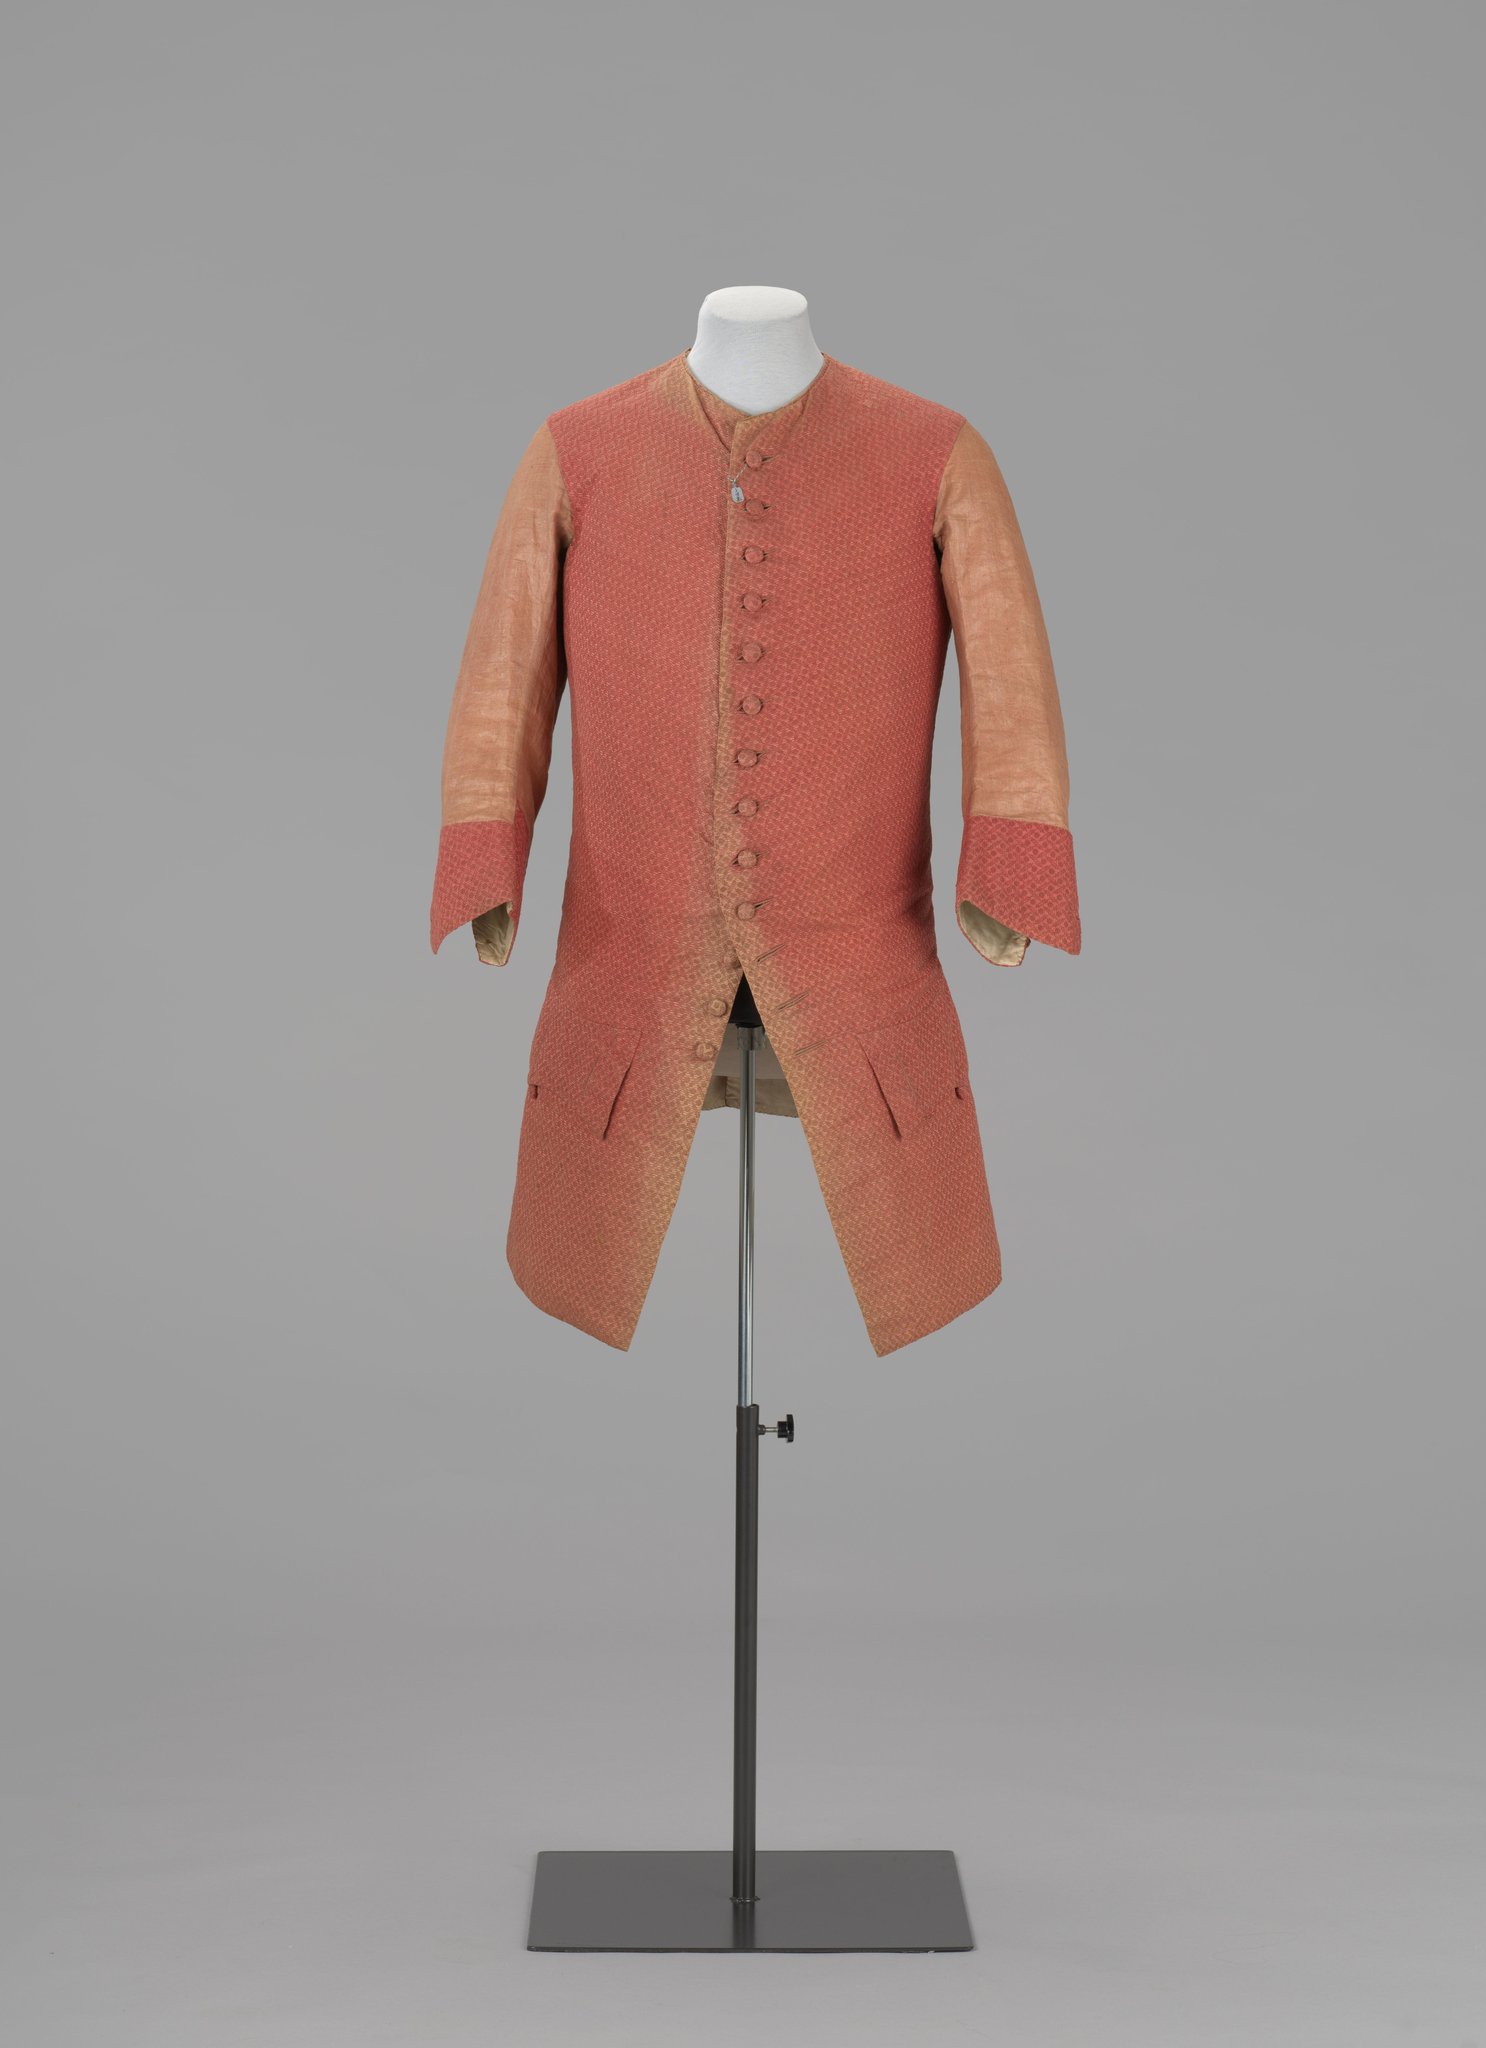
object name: menswear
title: Vest met ronde hals, okselgaten en 13 knopen en knoopsgaten, van rode gebrocheerde zijde met noppen; lange mouwen en rug grotendeels van bruin geglansd linnen (?).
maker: Anonymous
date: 1740-1760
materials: linen, silk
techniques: brocade